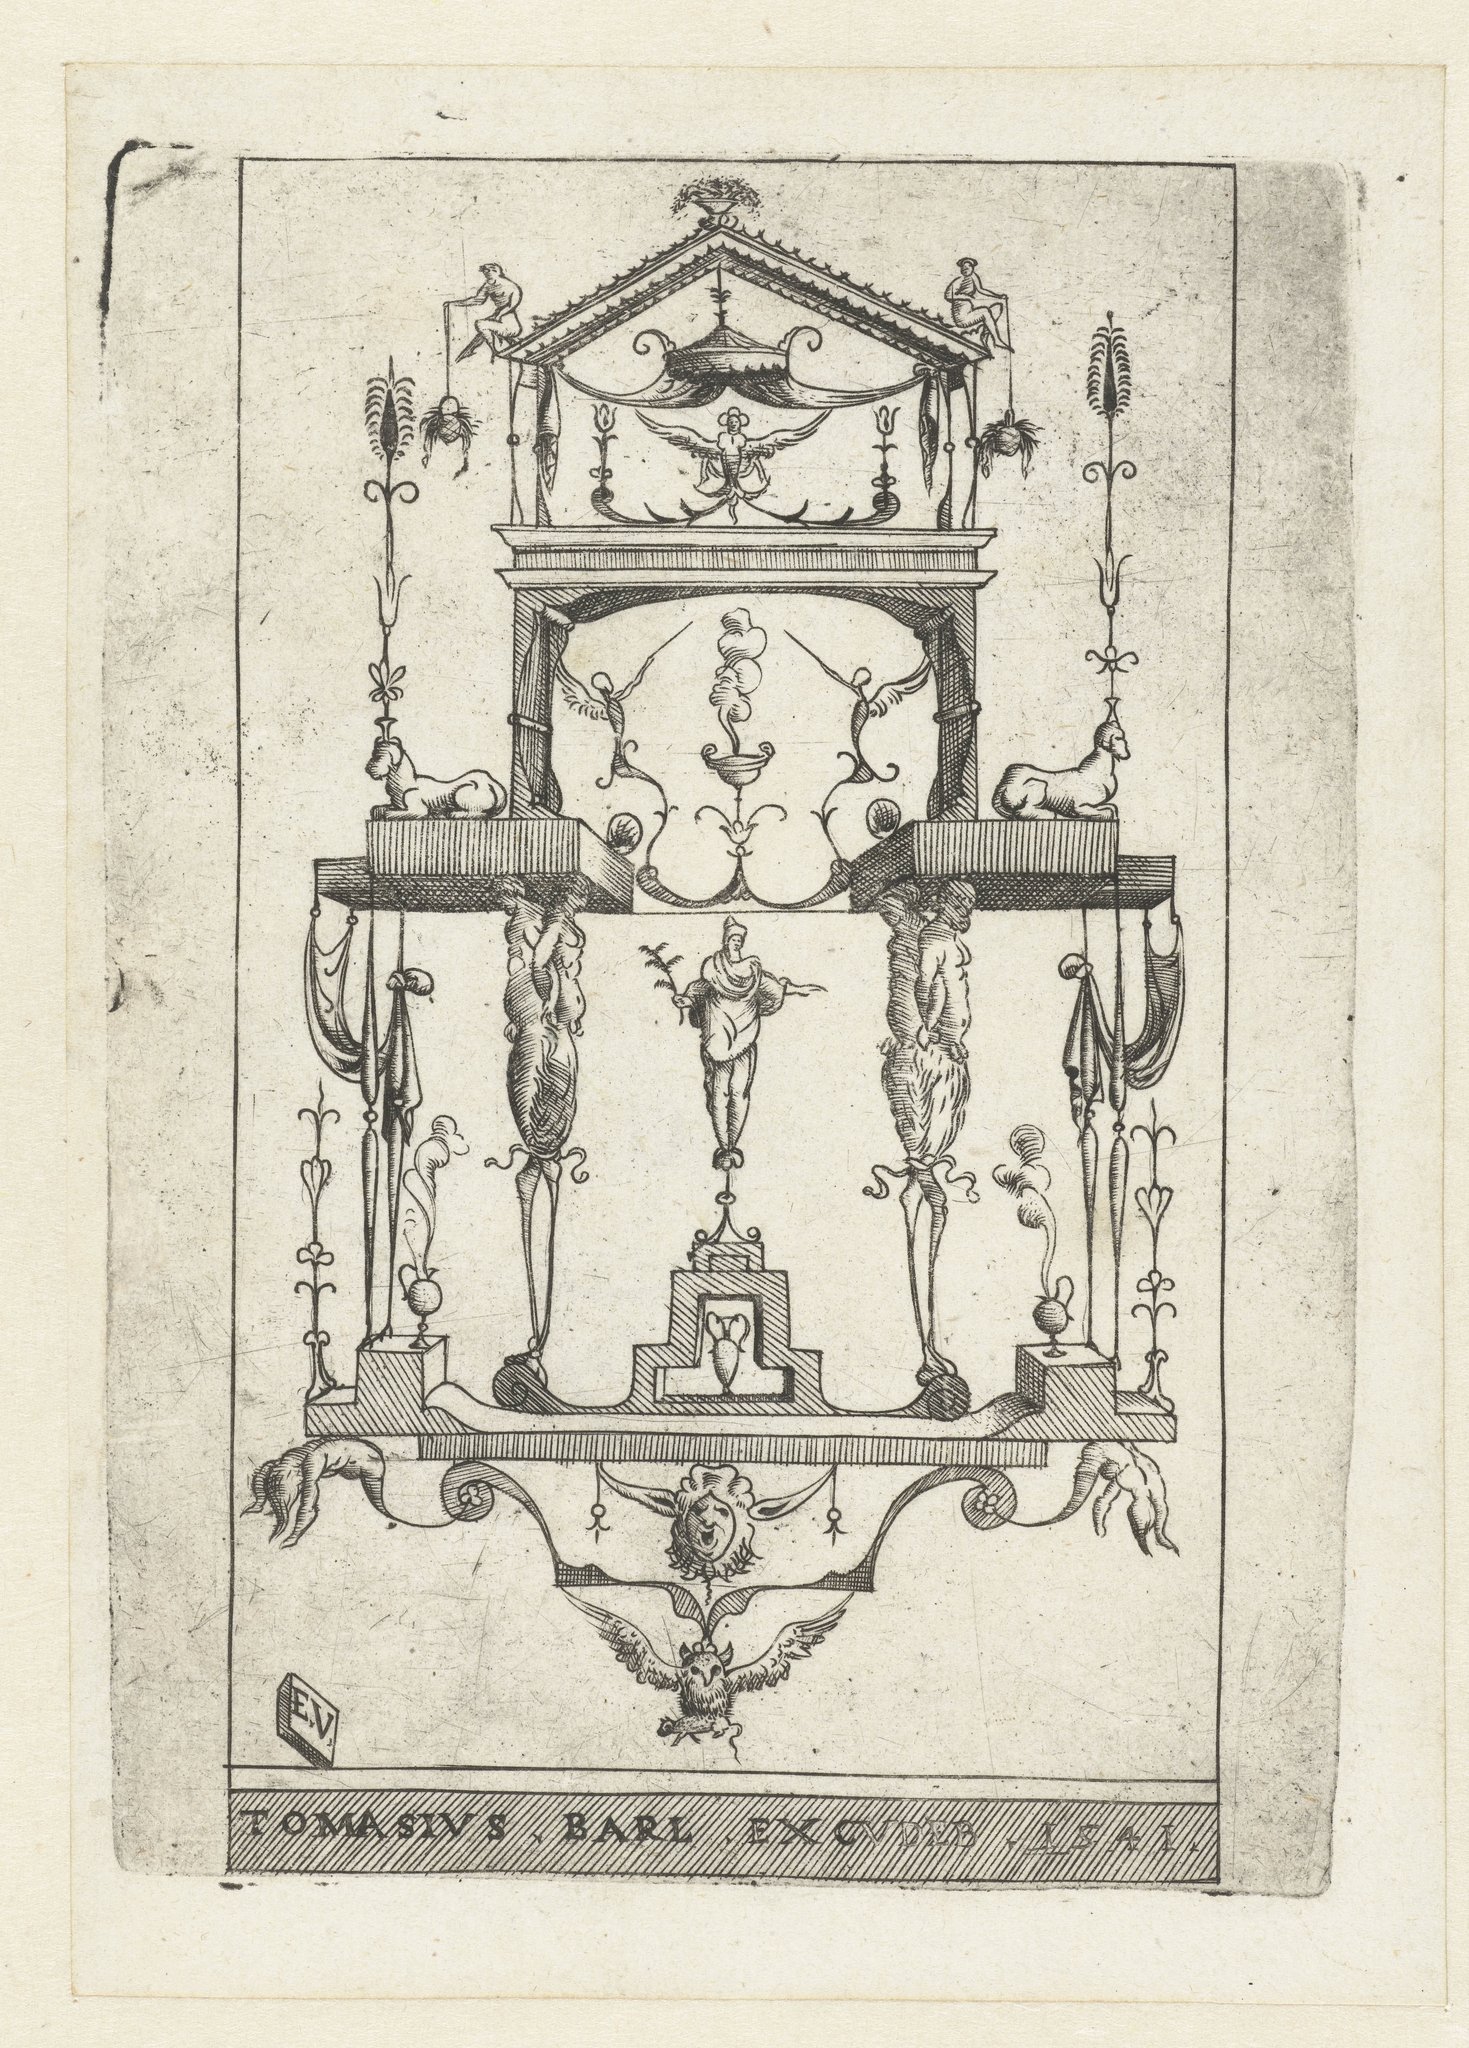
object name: print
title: Fantasie-bouwwerk, onderaan gesteund door twee dubbele hermen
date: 1533-1567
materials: paper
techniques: engraving, etching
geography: italy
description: In het gebouw staat een figuur met een tak in de hand op een voetstuk. Tegenzijdige kopie naar een anonieme prent uit de serie Leviores et ut videtur extemporaneae picturae quas grotteschas vulgo vocant...